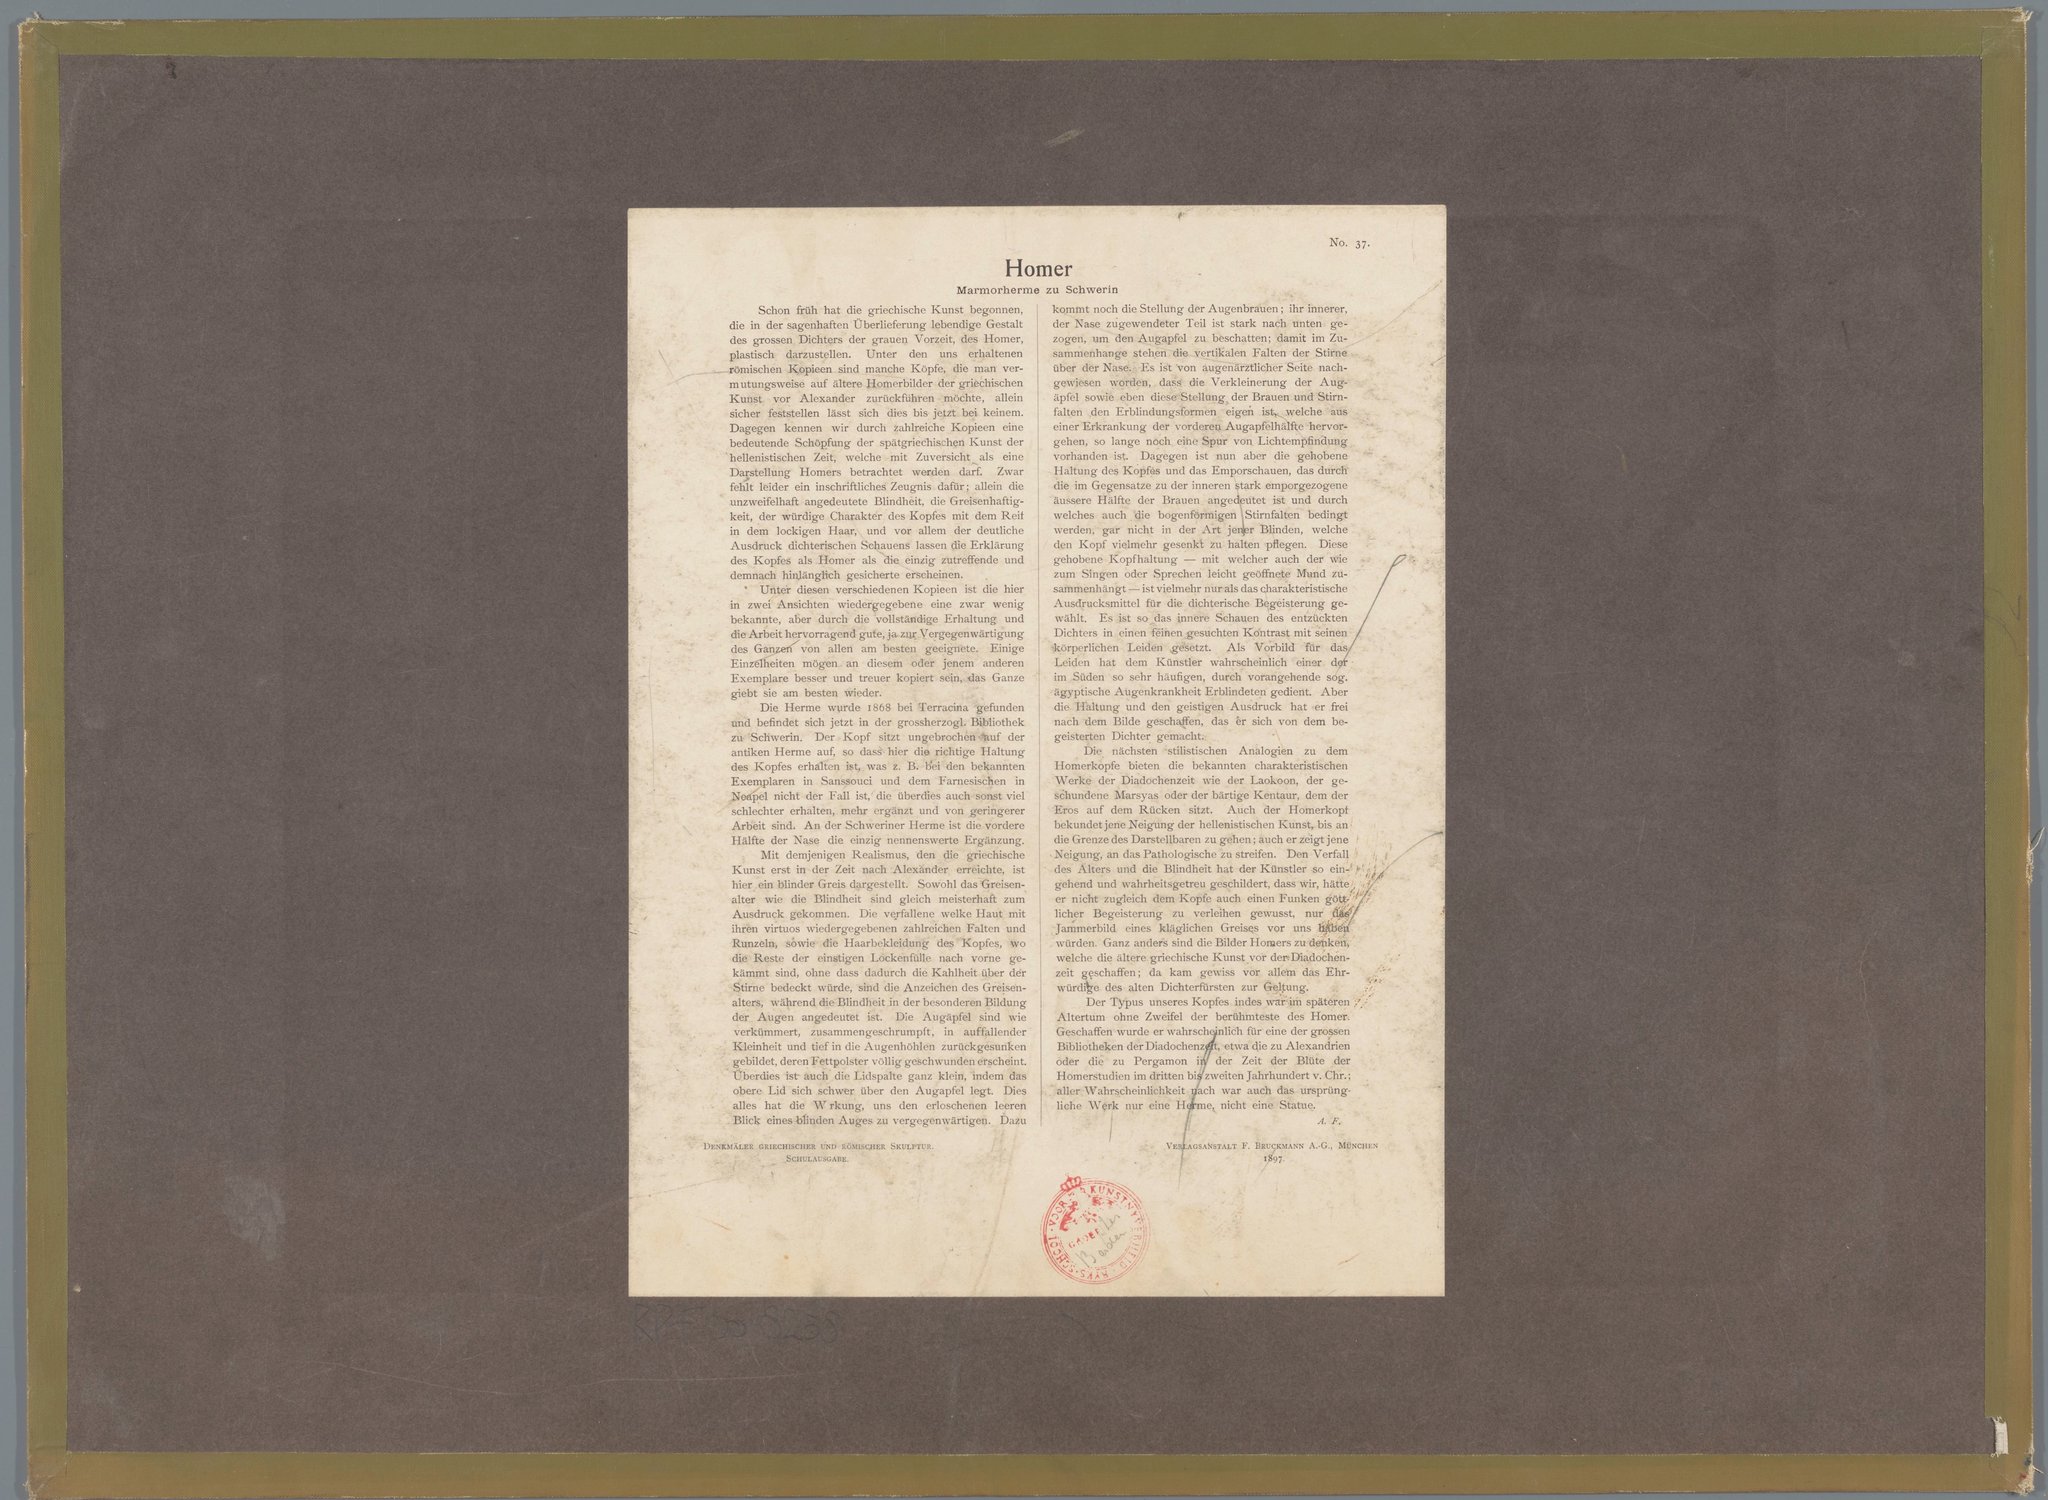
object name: photograph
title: Homer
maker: Anonymous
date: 1897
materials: cardboard, paper, ink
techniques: photograph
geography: munich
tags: idealized portrait of homer, blind and wearing a crown of laurel, sculpture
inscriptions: number: ‘No. 37.’, inscription:, collector's mark: Lugt 3937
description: Links een vooraanzicht, rechts een zijaanzicht.